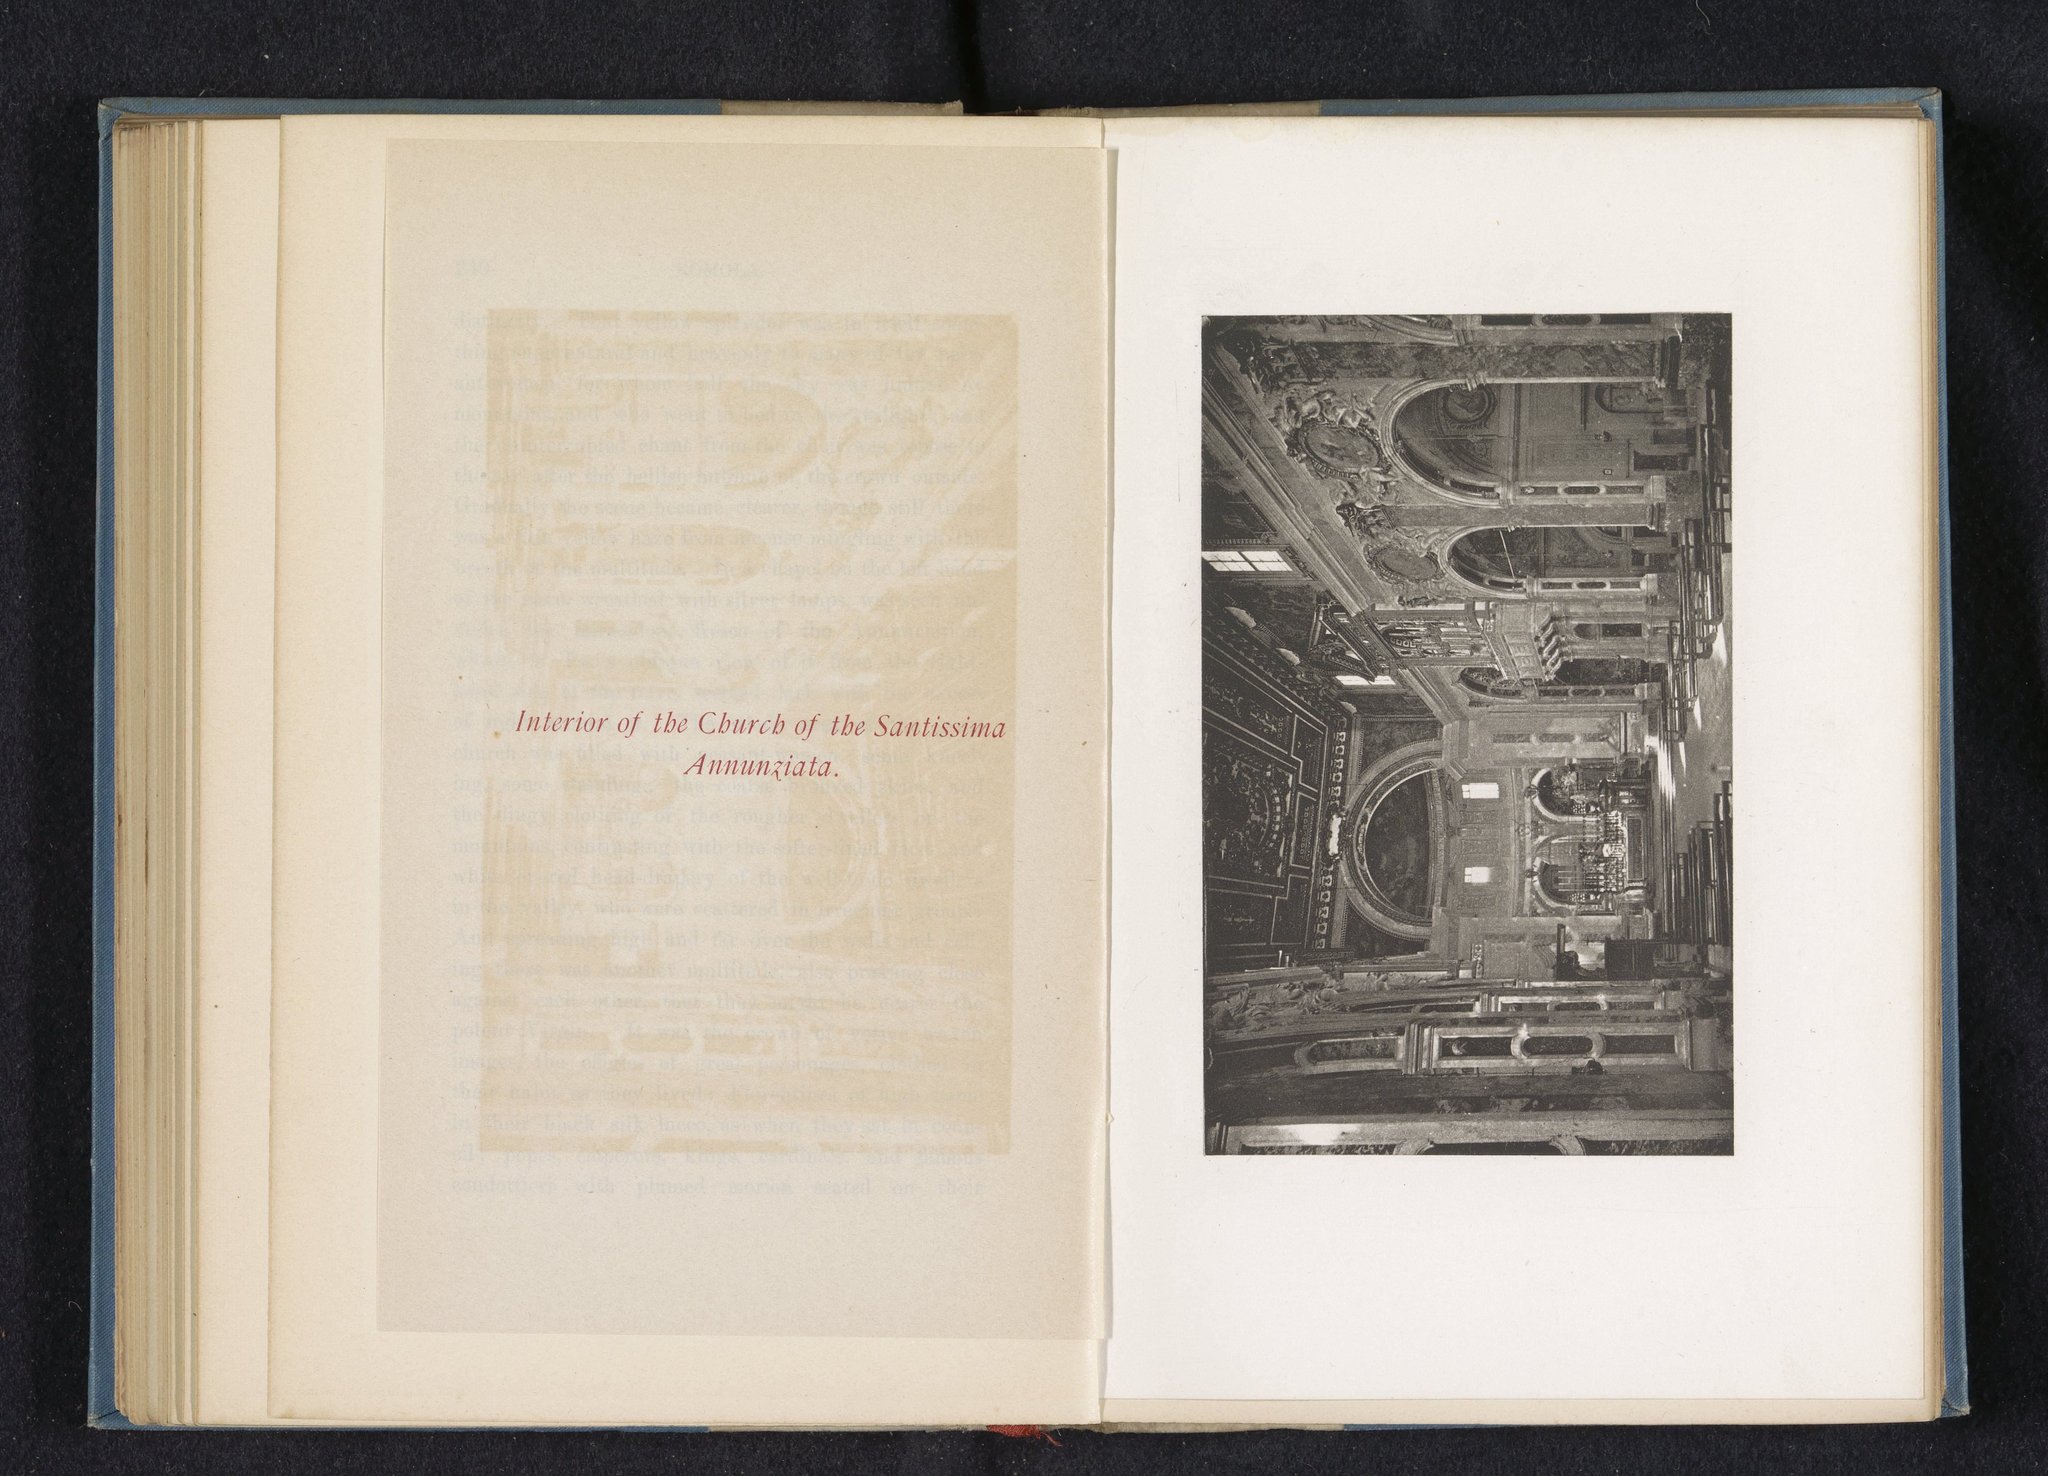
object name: page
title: Interieur van de Basilica della Santissima Annunziata te Florence met zicht op het koor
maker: Anonymous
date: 1880-1890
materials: paper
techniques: photoaquatint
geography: basilica della santissima annunziata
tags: interior of church, parts of church interior: choir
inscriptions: title: ‘Interior of the Church of the Santissima Annunziata.’